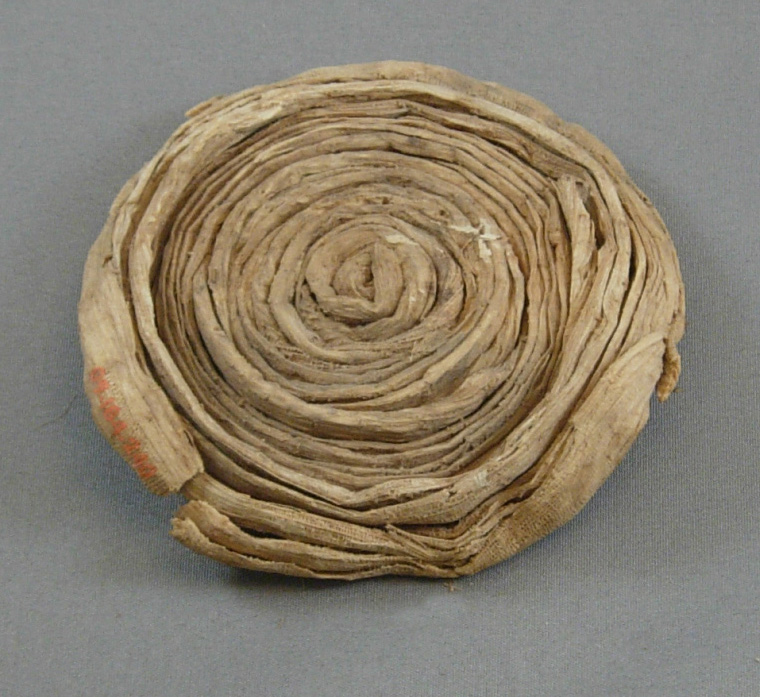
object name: jar lid papyrus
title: Papyrus Lid from Tutankhamun's Embalming Cache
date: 1336-1327 BCE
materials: fiber, papyrus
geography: egypt